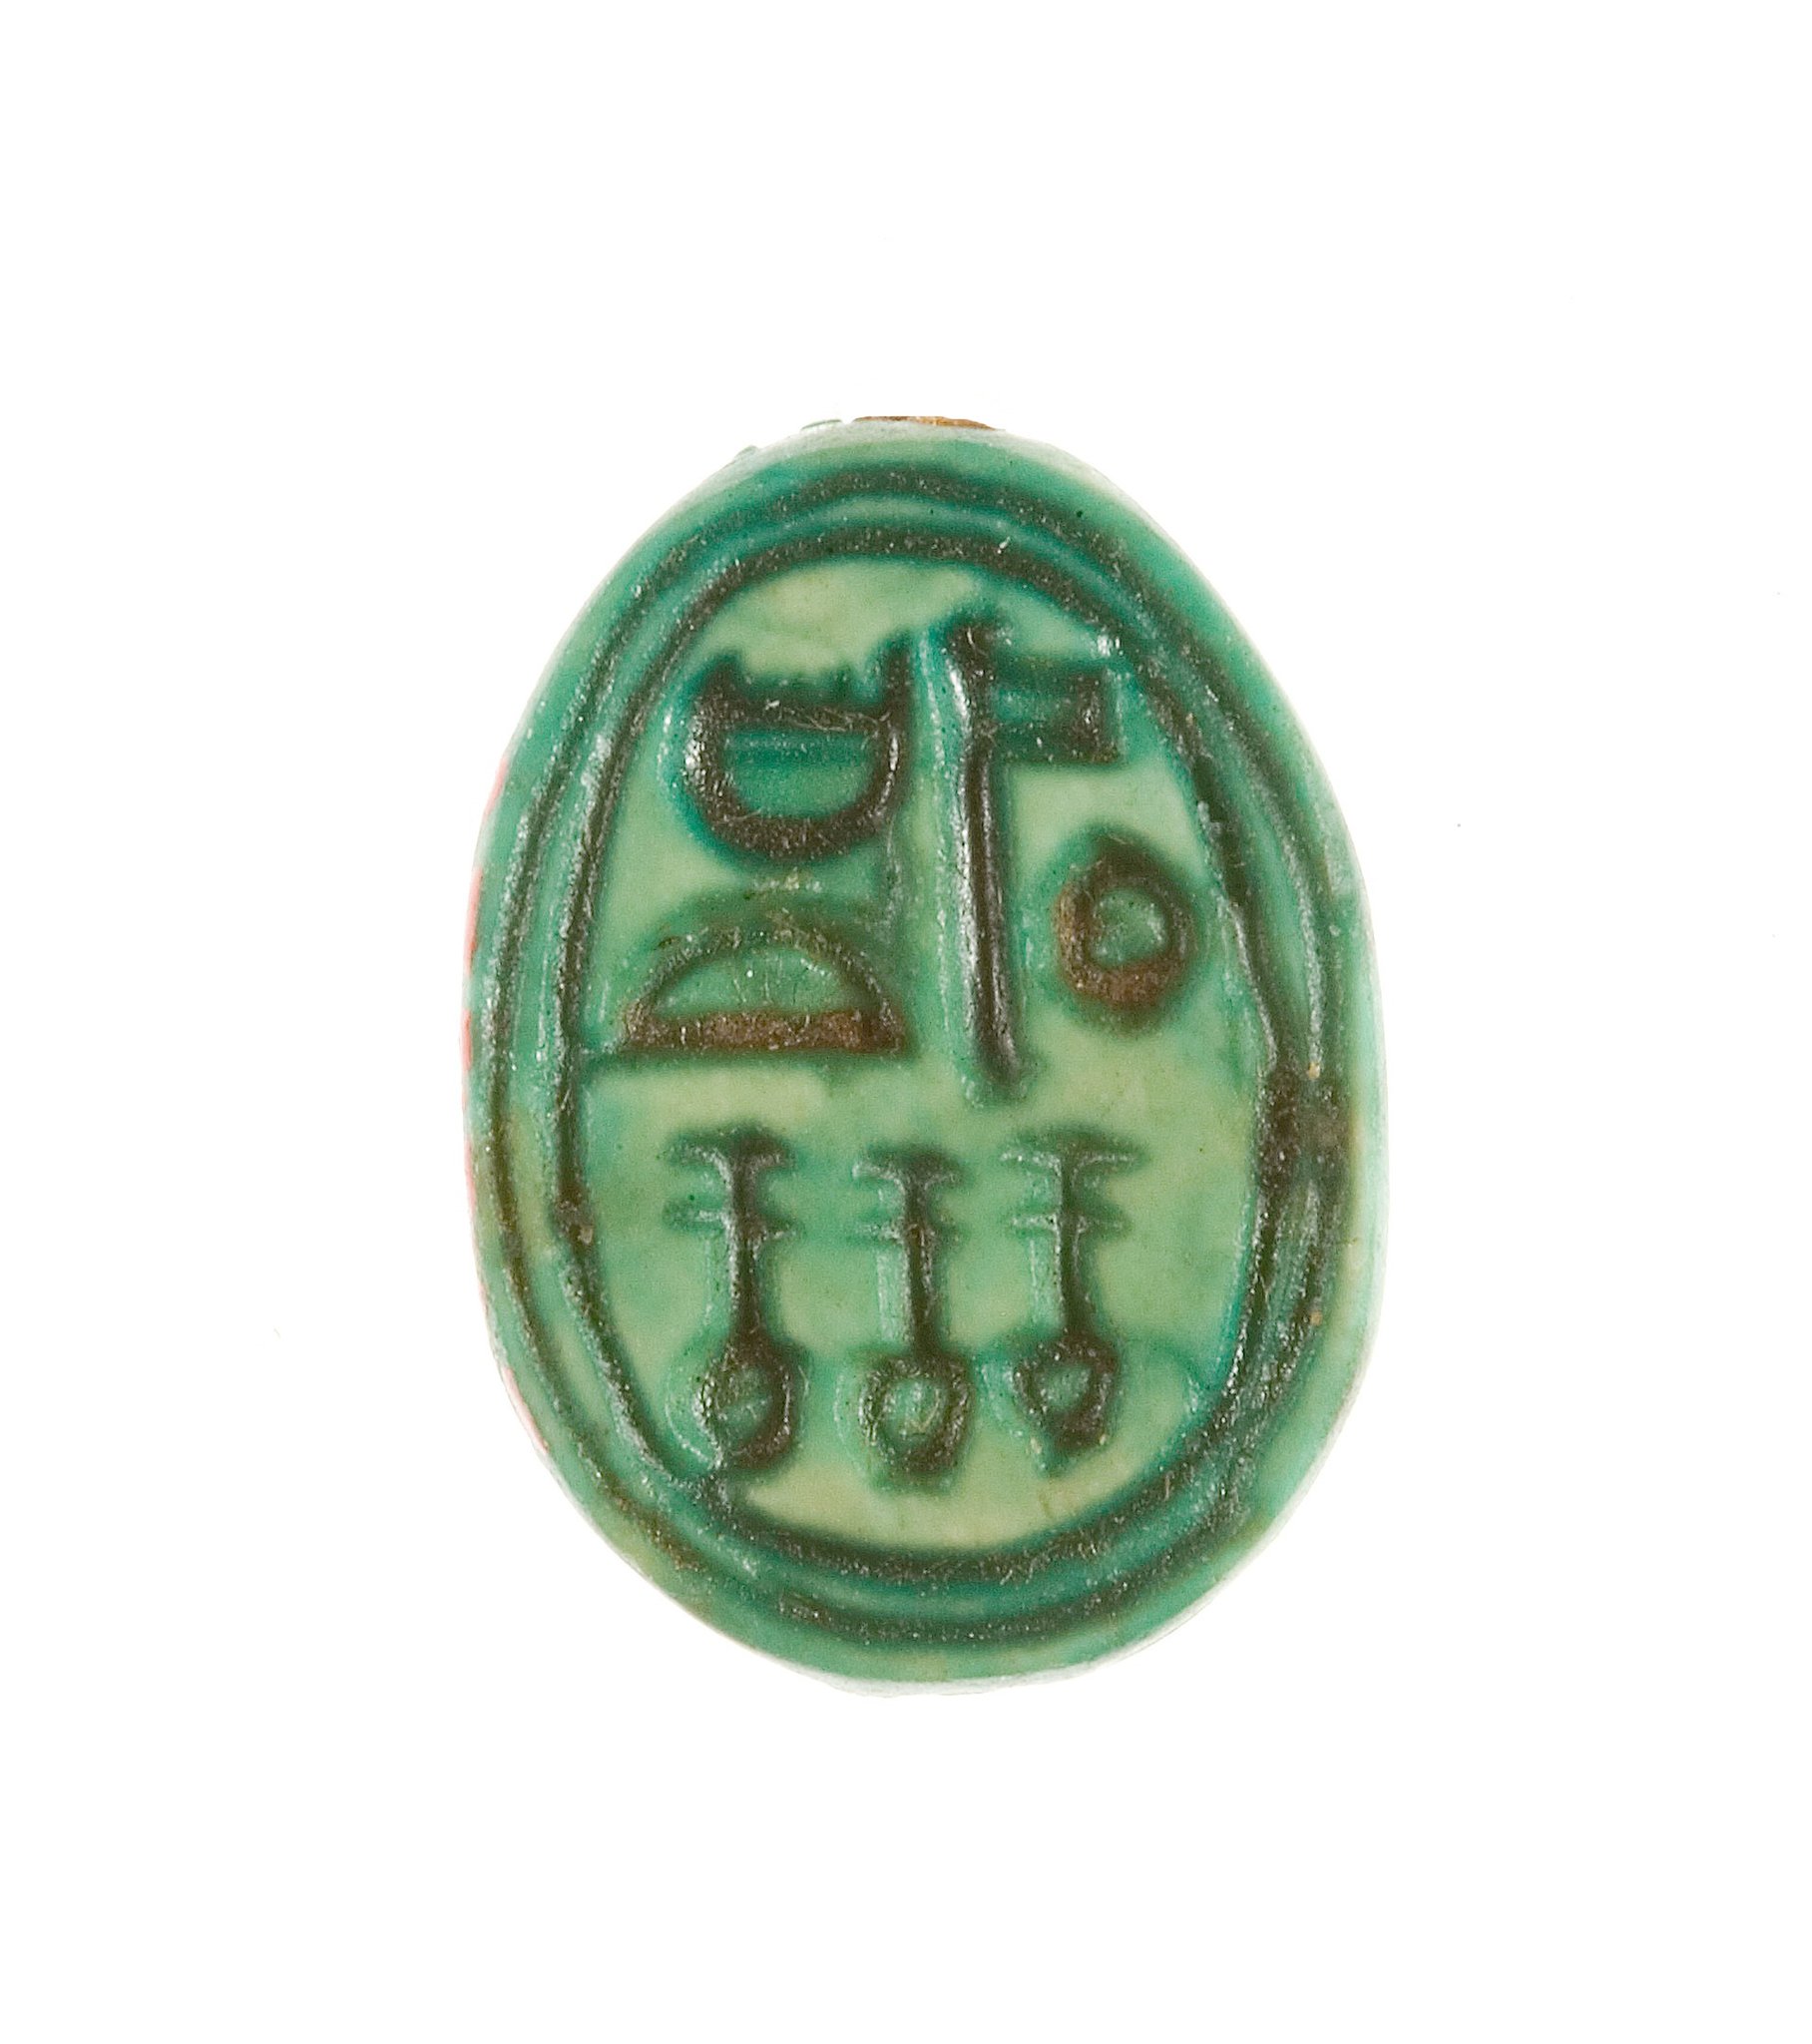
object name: scarab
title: Scarabs Inscribed for the God's Wife Neferure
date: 1479-1458 BCE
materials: stone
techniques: glazing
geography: egypt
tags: scarabs